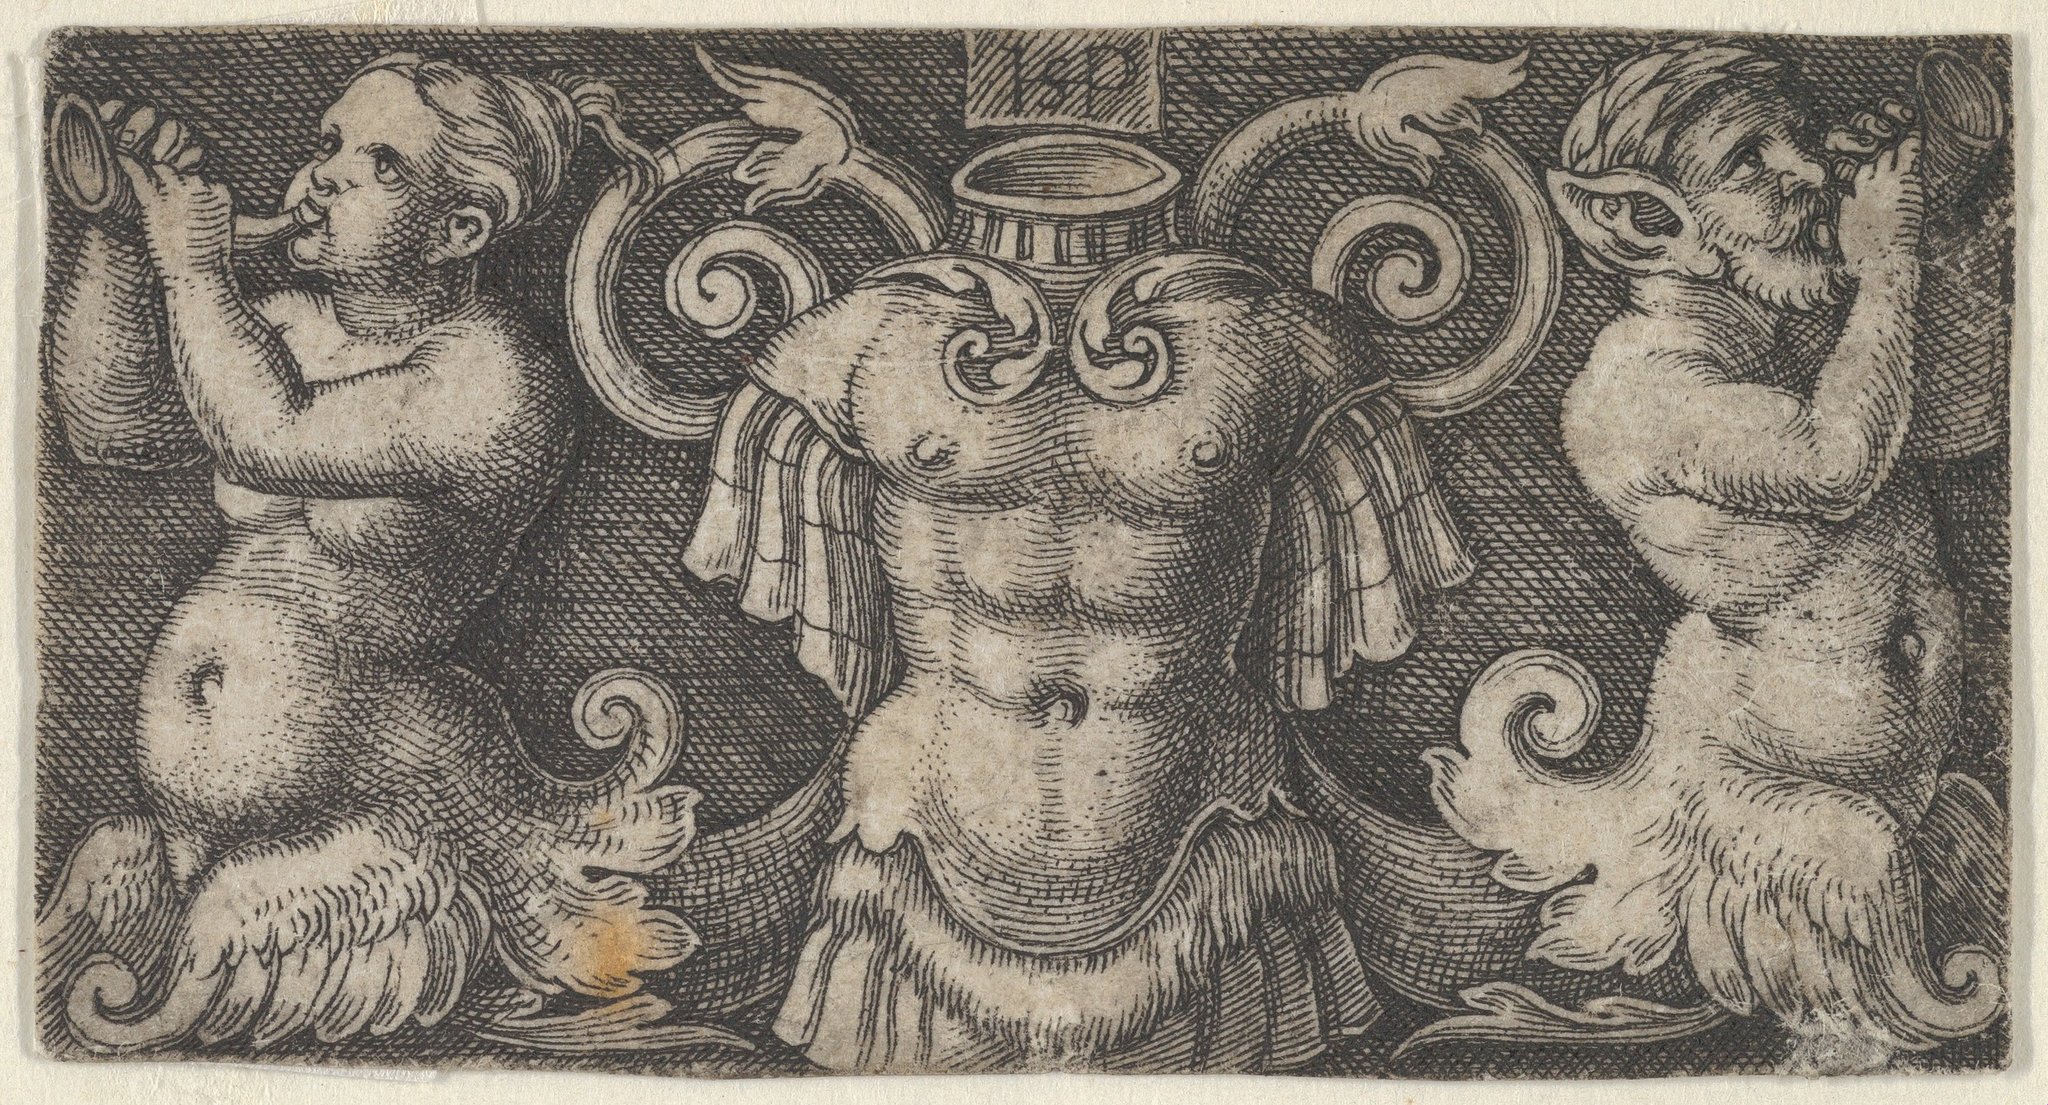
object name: print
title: Horizontal Panel with Armour at Center, Flanked by Two Tritons Playing the Horn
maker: sebald beham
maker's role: artist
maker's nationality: german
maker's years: 1500-1550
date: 1518-1530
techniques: engraving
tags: armor,horns,triton